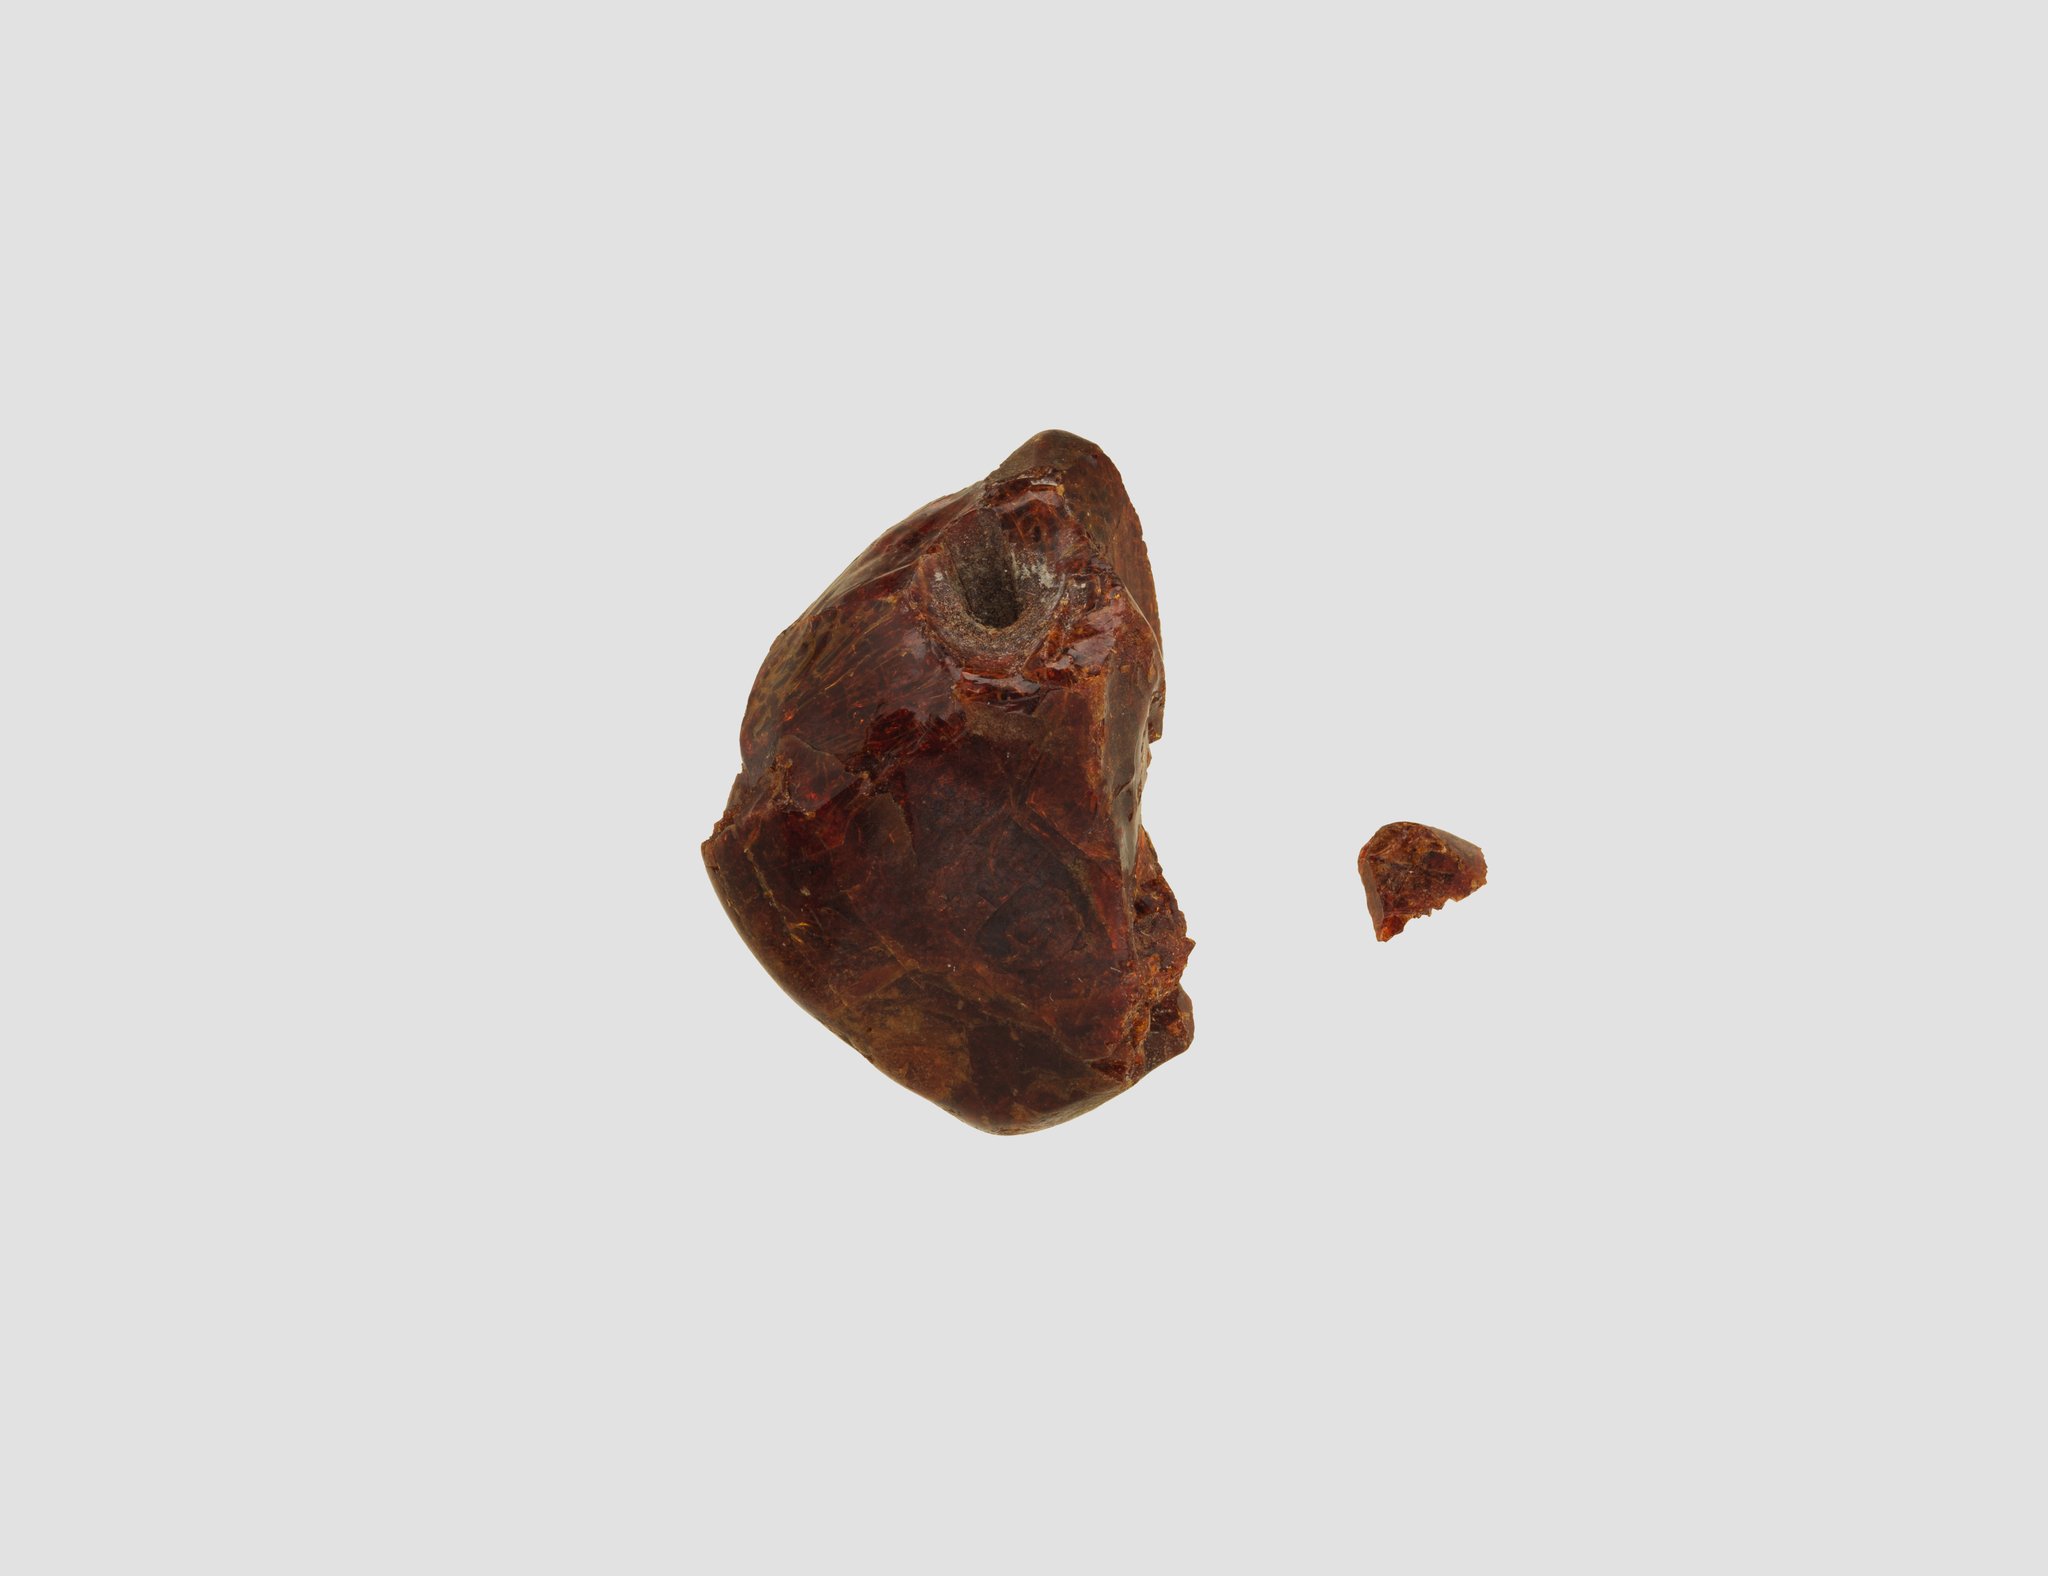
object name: bead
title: Broken bead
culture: iranian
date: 900-801 BCE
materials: amber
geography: iran